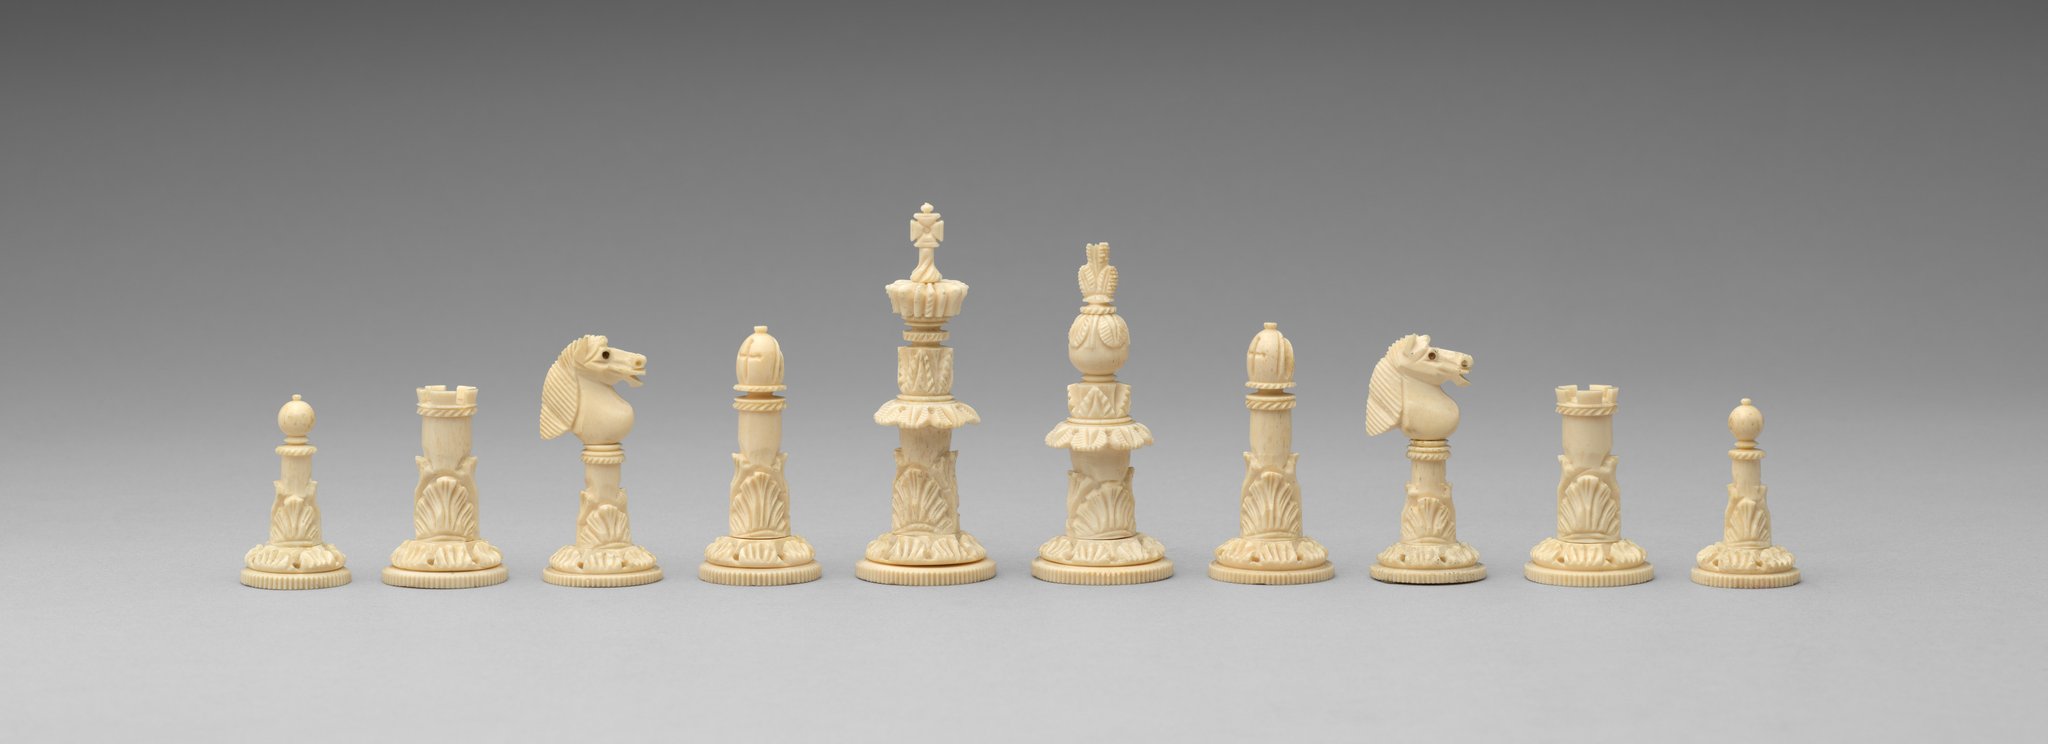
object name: chessman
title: Chessmen (32)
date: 1834-1866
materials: bone, ivory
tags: chess